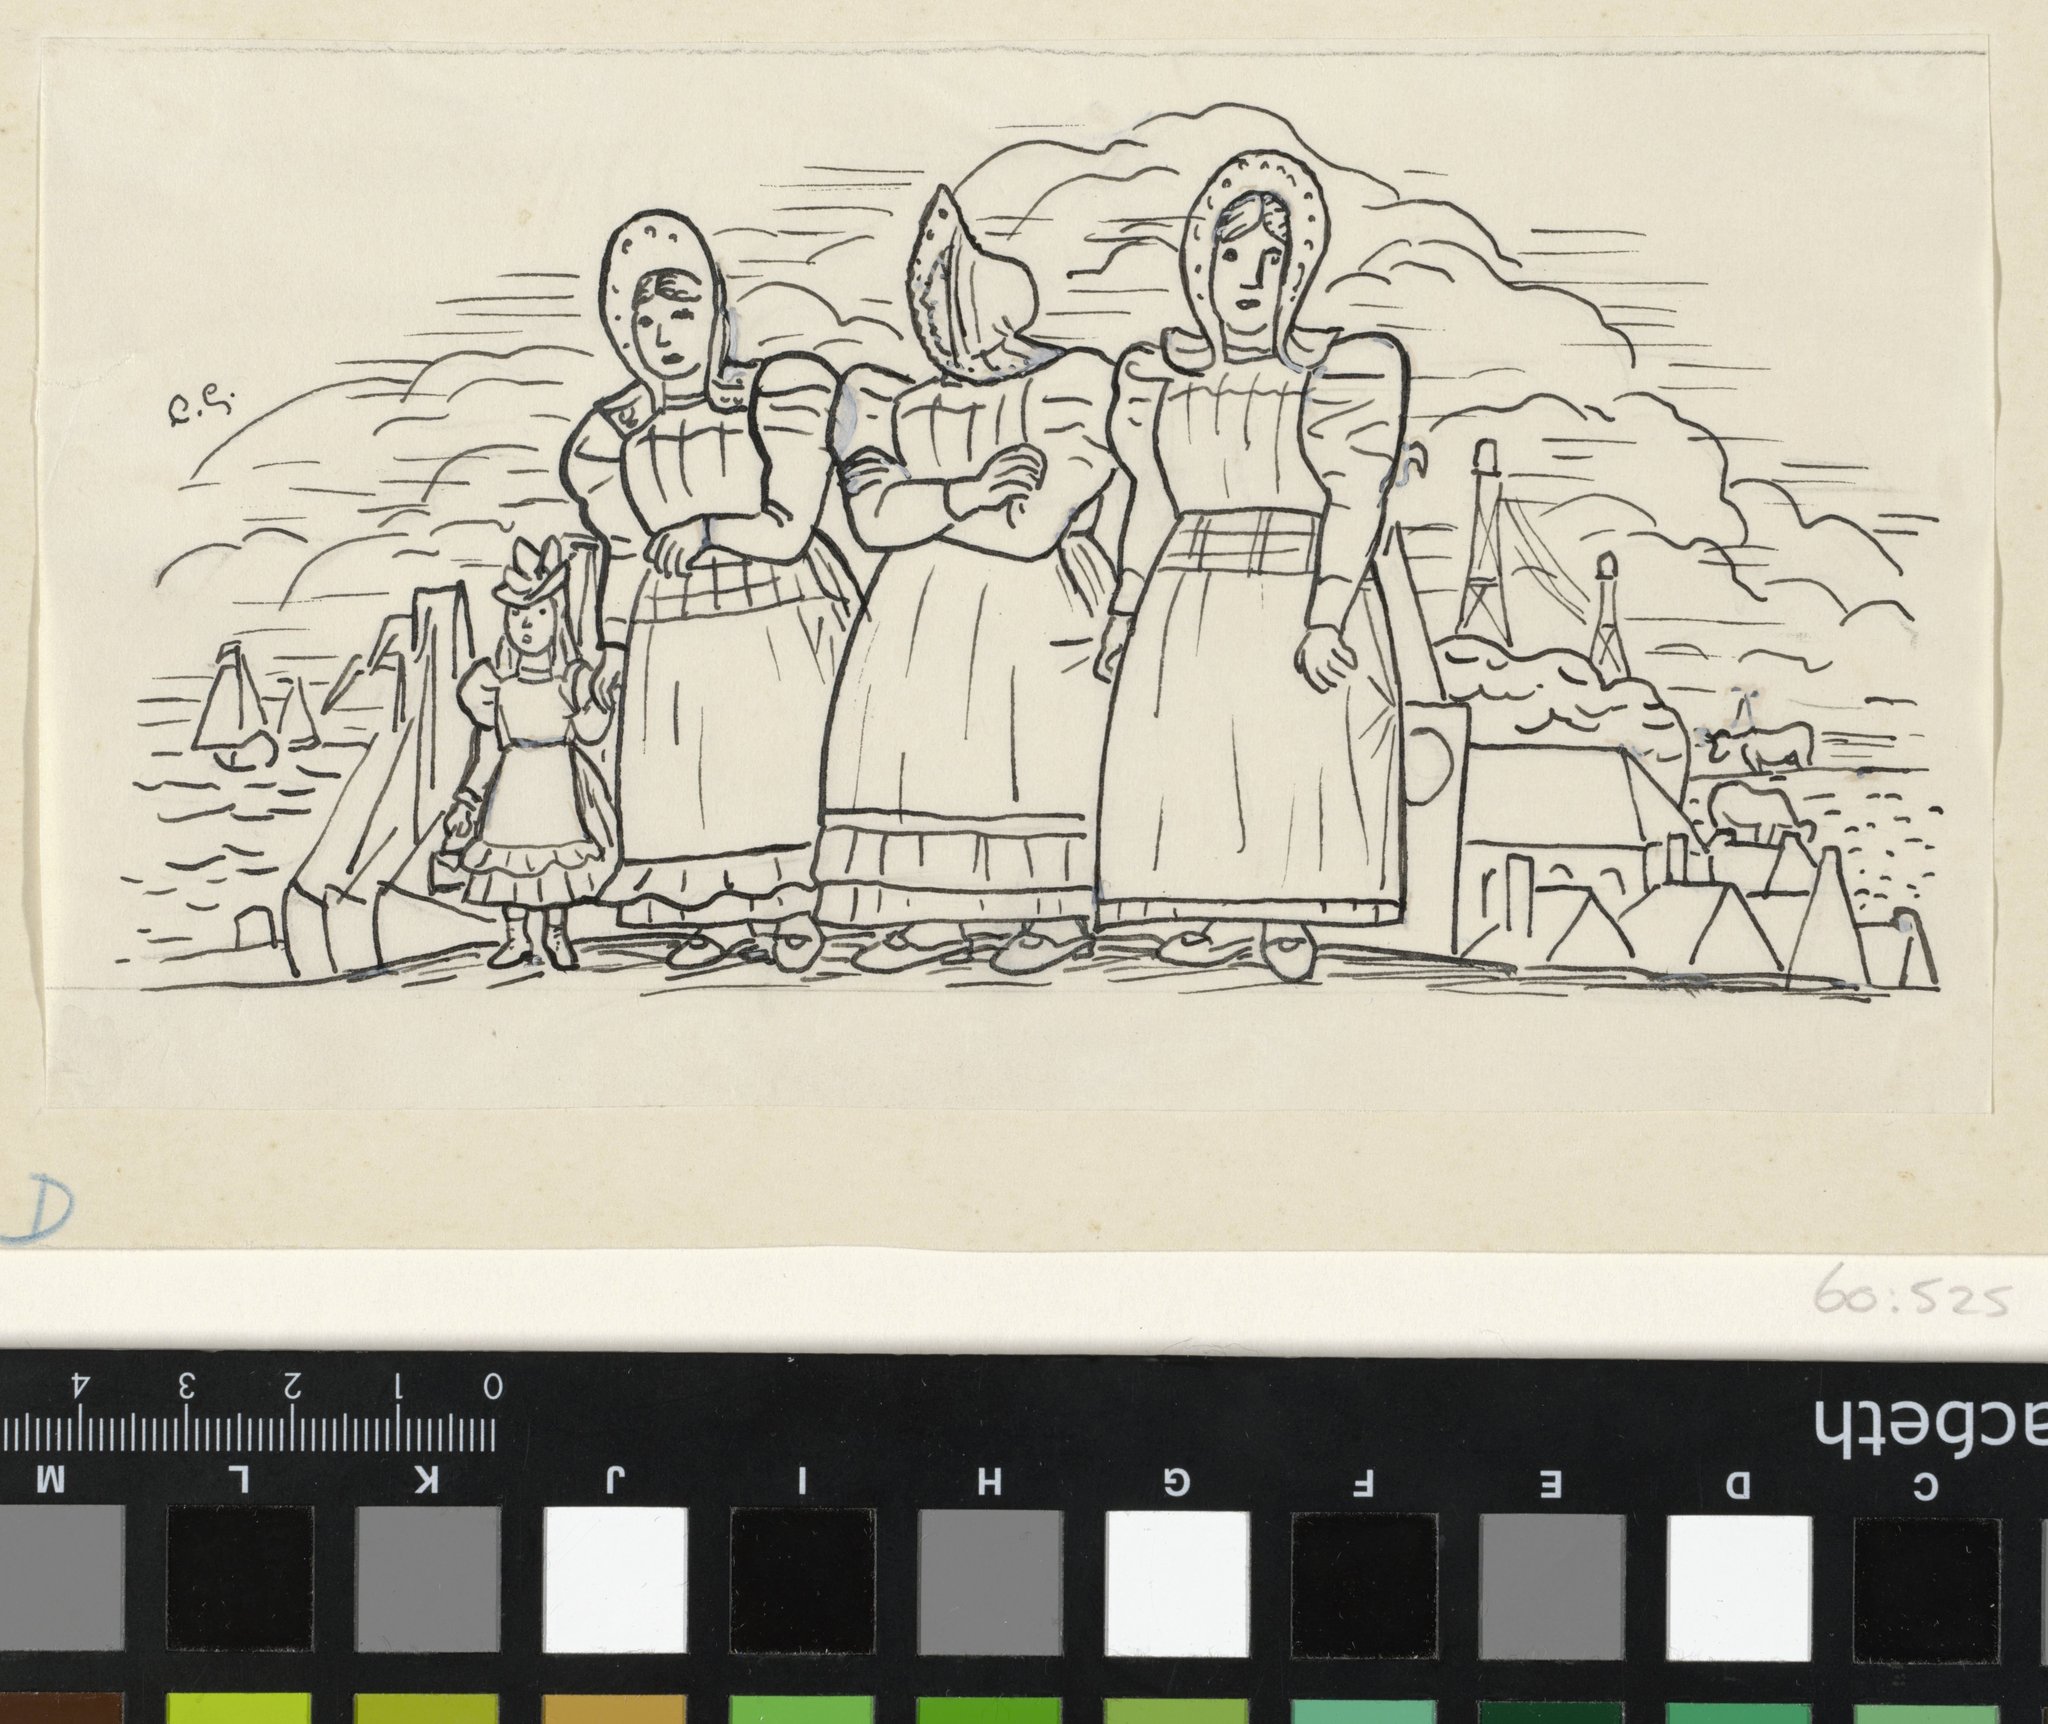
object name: design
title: Drie vissersvrouwen en een meisje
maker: leo gestel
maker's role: draughtsman, print maker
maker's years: 1881-1941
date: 1891-1941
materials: paint, ink, paper, pencil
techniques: pen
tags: female sex; woman, girl (child between toddler and youth)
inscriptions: collector's mark: Lugt 2228